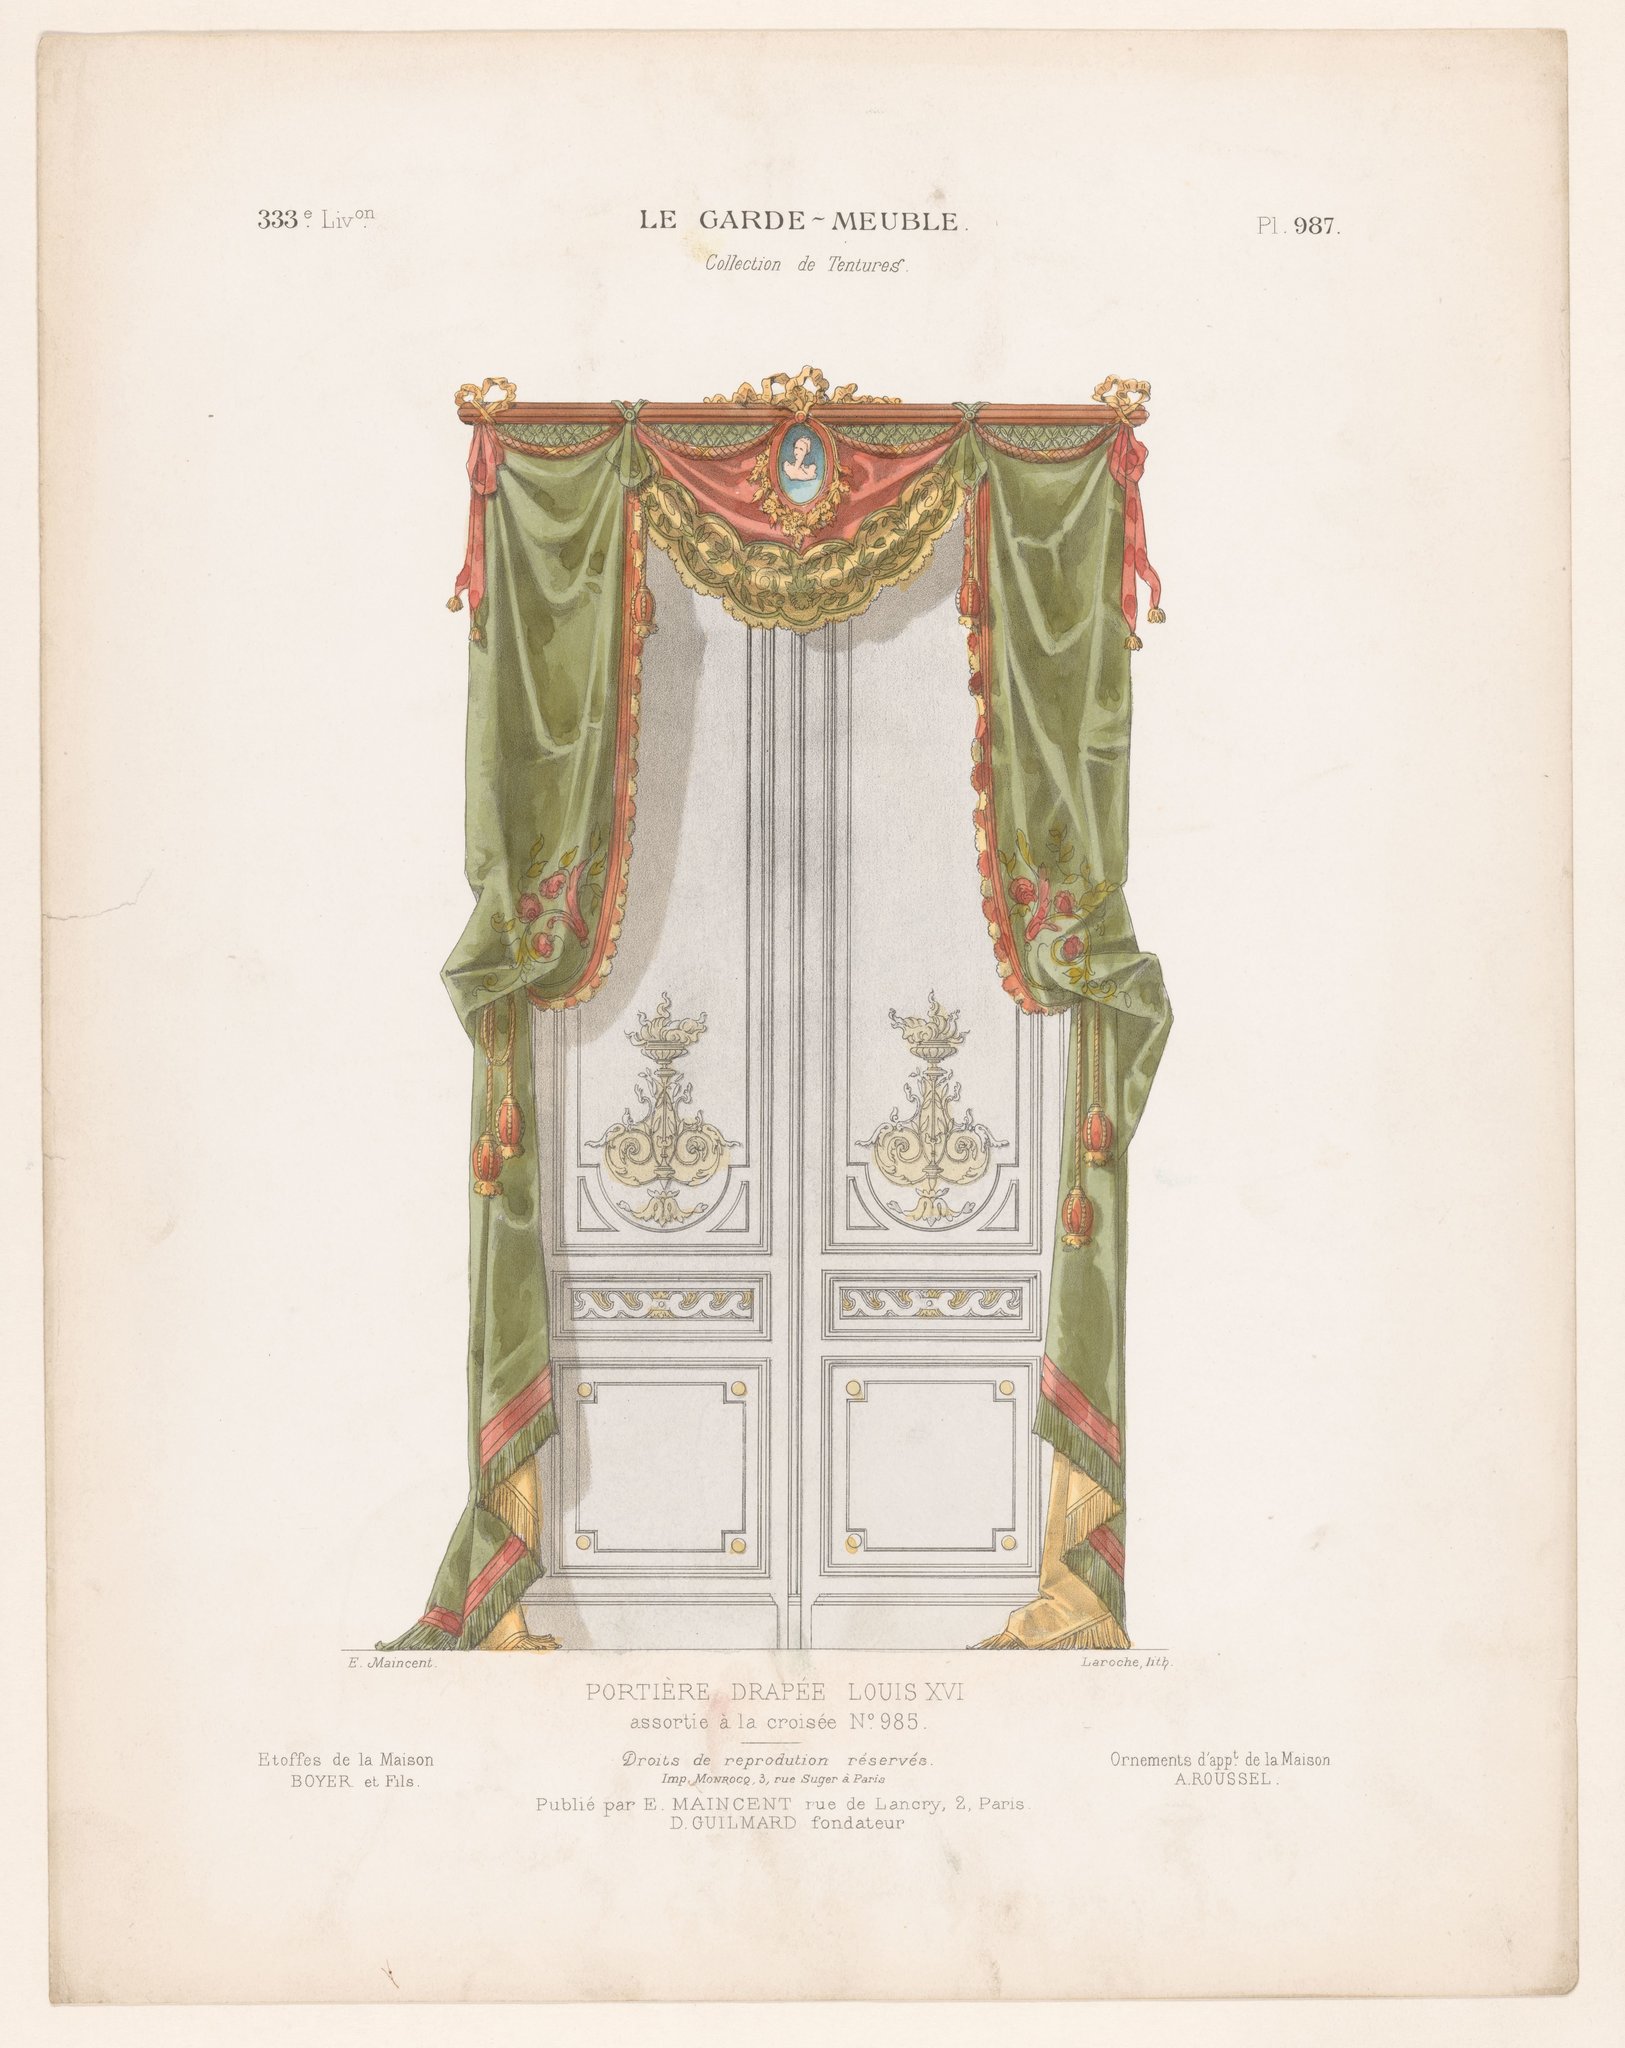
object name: print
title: Portière drapée Louis XVI / assortie à la croisée no. 985.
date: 1885-1895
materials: paper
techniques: hand coloring, lithograph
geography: paris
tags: door, hangings and drapery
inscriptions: : ‘Droits de reproduction réservés.’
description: Deur met gedrapeerde gordijnen in de Lodewijk XVI-stijl, passend bij serienr. 985. Prent uit 333e Livraison.